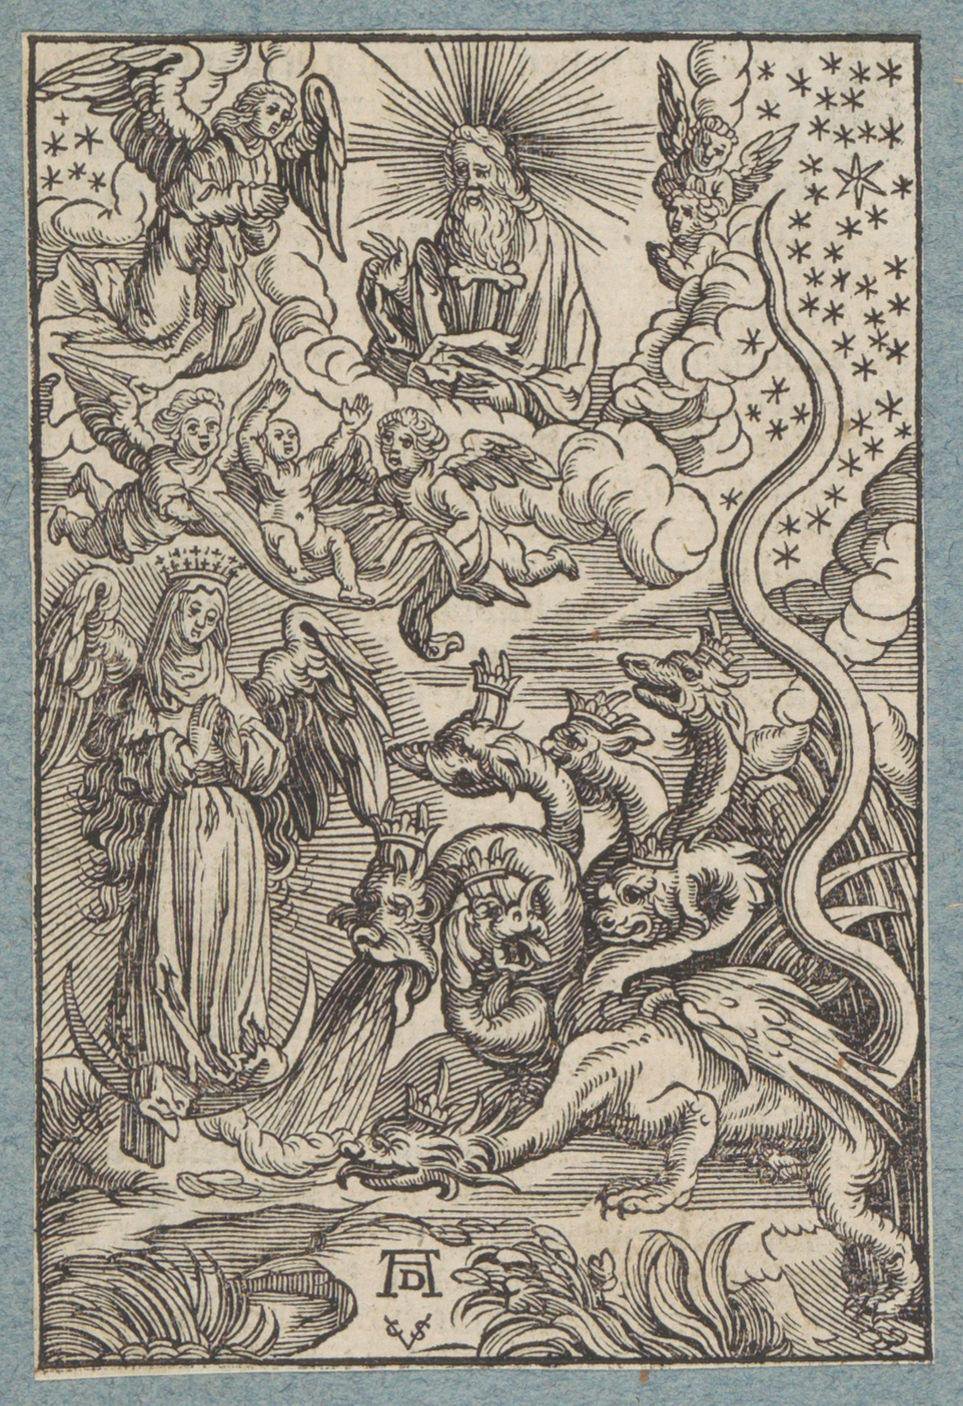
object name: album leaf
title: Apocalyptische vrouw en de zevenkoppige draak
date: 1629-1646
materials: paper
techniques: letterpress printing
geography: nuremberg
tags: a pregnant woman, clothed with the sun and standing on the moon, appears; she is threatened by a red dragon with a long tail and seven heads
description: De prent is afkomstig uit een van de uitgaven van P.J. Paets uit Amsterdam. De prent wordt mogelijk al gebruikt voor: Der Zielen Lust-hof. Leuven, I.Jacbosz voor P.J. Paets [= Amsterdam, P.J. Paets], 1629. Ze komt in ieder geval voor in: Het Nieuwe Testament ons Salichmaeckers Jesu Christi. Amsterdam, P.J. Paets, 1646.